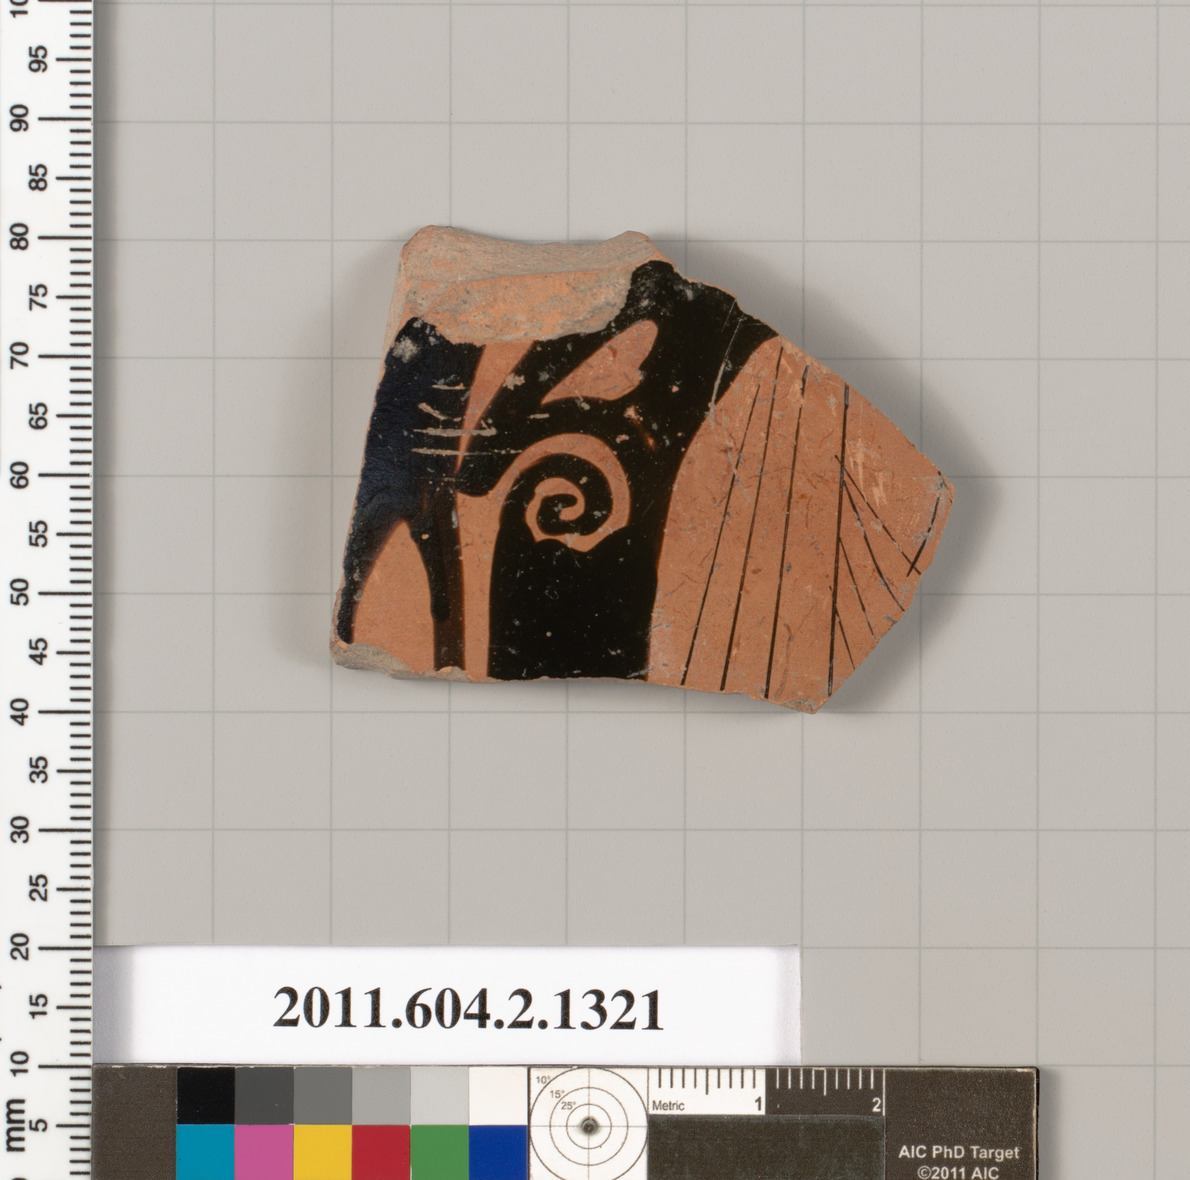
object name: skyphos fragment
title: Terracotta fragment of a skyphos (deep drinking cup)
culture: greek, attic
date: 450-426 BCE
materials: terracotta